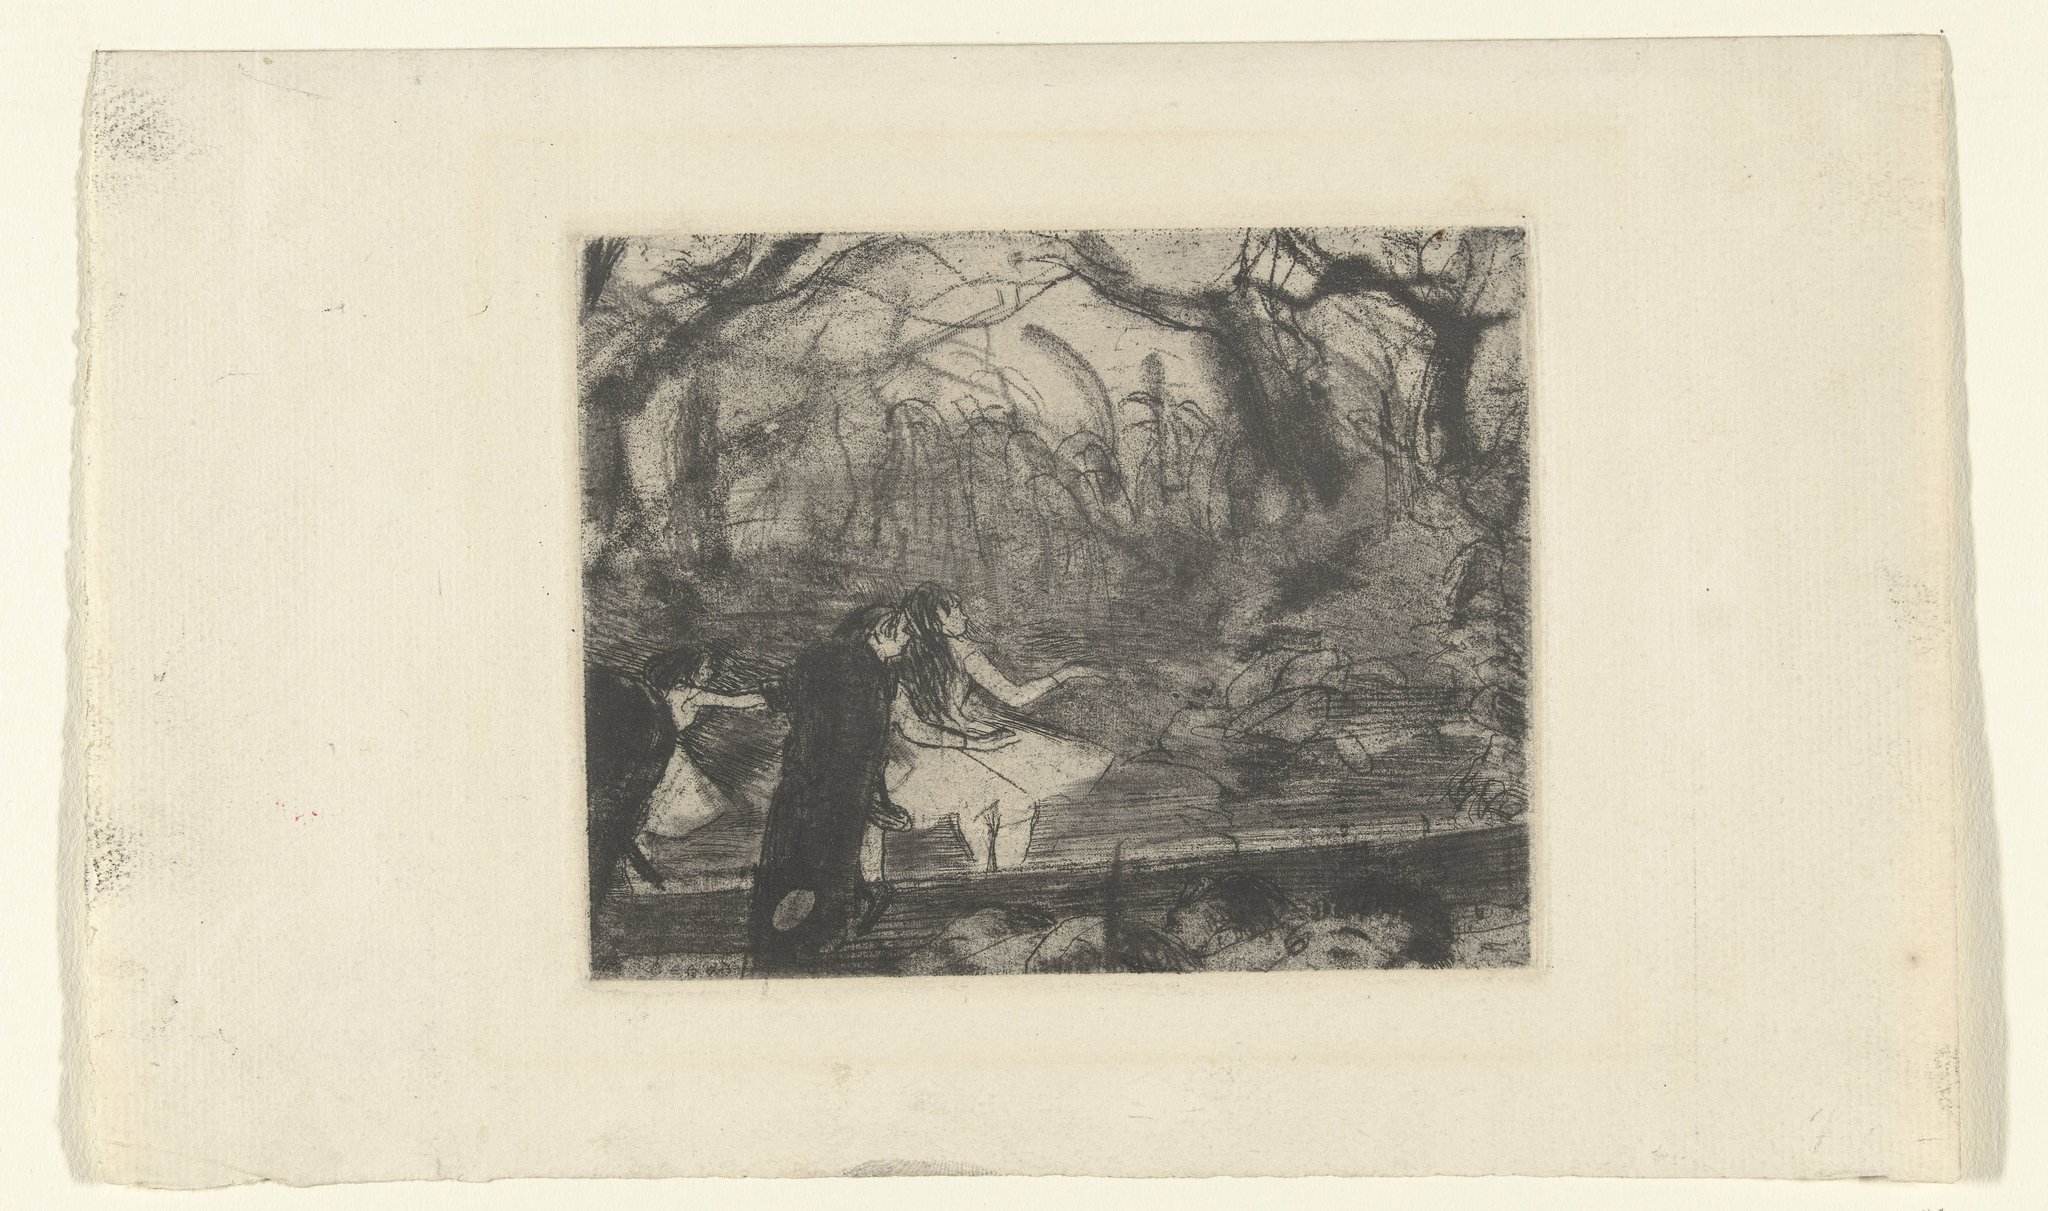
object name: print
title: Podium met balletvoorstelling en toeschouwers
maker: edgar degas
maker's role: draughtsman, painter, print maker, sculptor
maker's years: 1834-1917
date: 1876-1877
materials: paper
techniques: drypoint, roulette, soft ground etching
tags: ballet group; dancers on the stage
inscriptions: collector's mark: Lugt 2228, workshop stamp: Lugt 657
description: Van de vijfde staat verschenen meer drukken dan van de andere staten want deze prent werd gebruikt voor een tentoonstellingscatalogus met originele etsen van elf hedendaagse impressionisten op initiatief van Les Amis des Arts de Pau. De vijfde staat onderscheid zich door een schone plaatrand, zie Welsh Reed & Stern Shapiro 1984, p. 68-72.